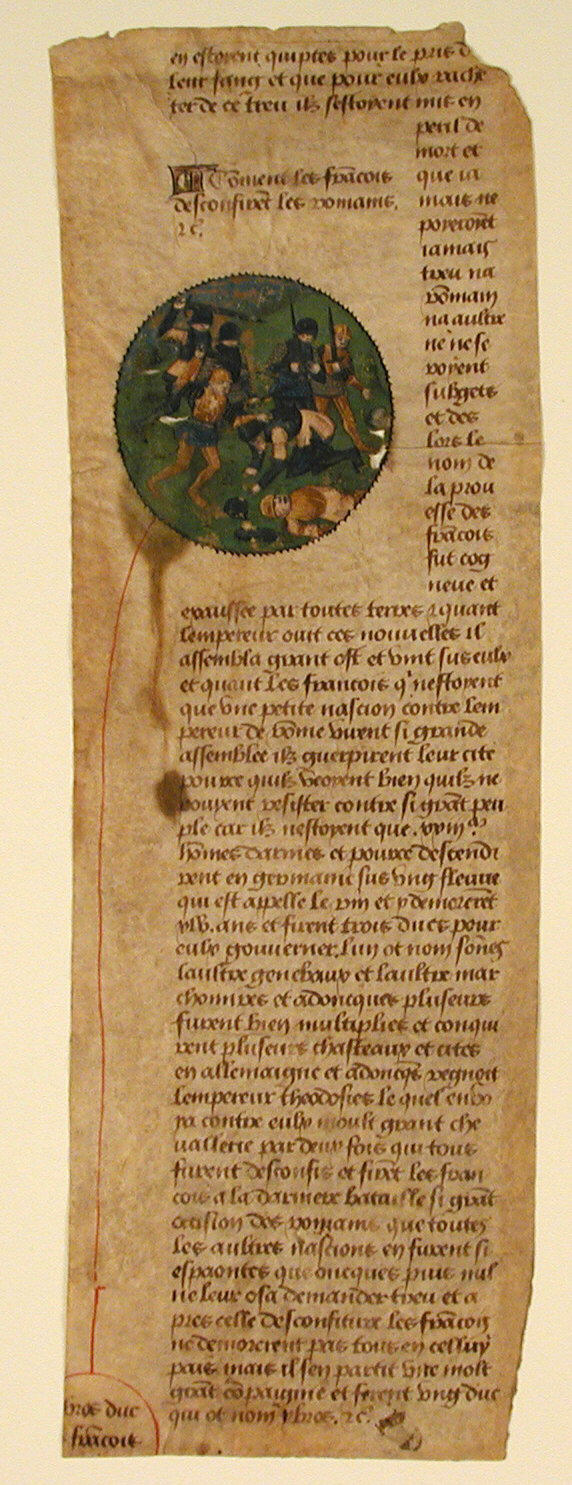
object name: manuscript cutting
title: Manuscript Cutting from the Grande Chroniques de France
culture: french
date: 1434-1466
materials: ink, metal leaf, parchment, paint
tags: battles